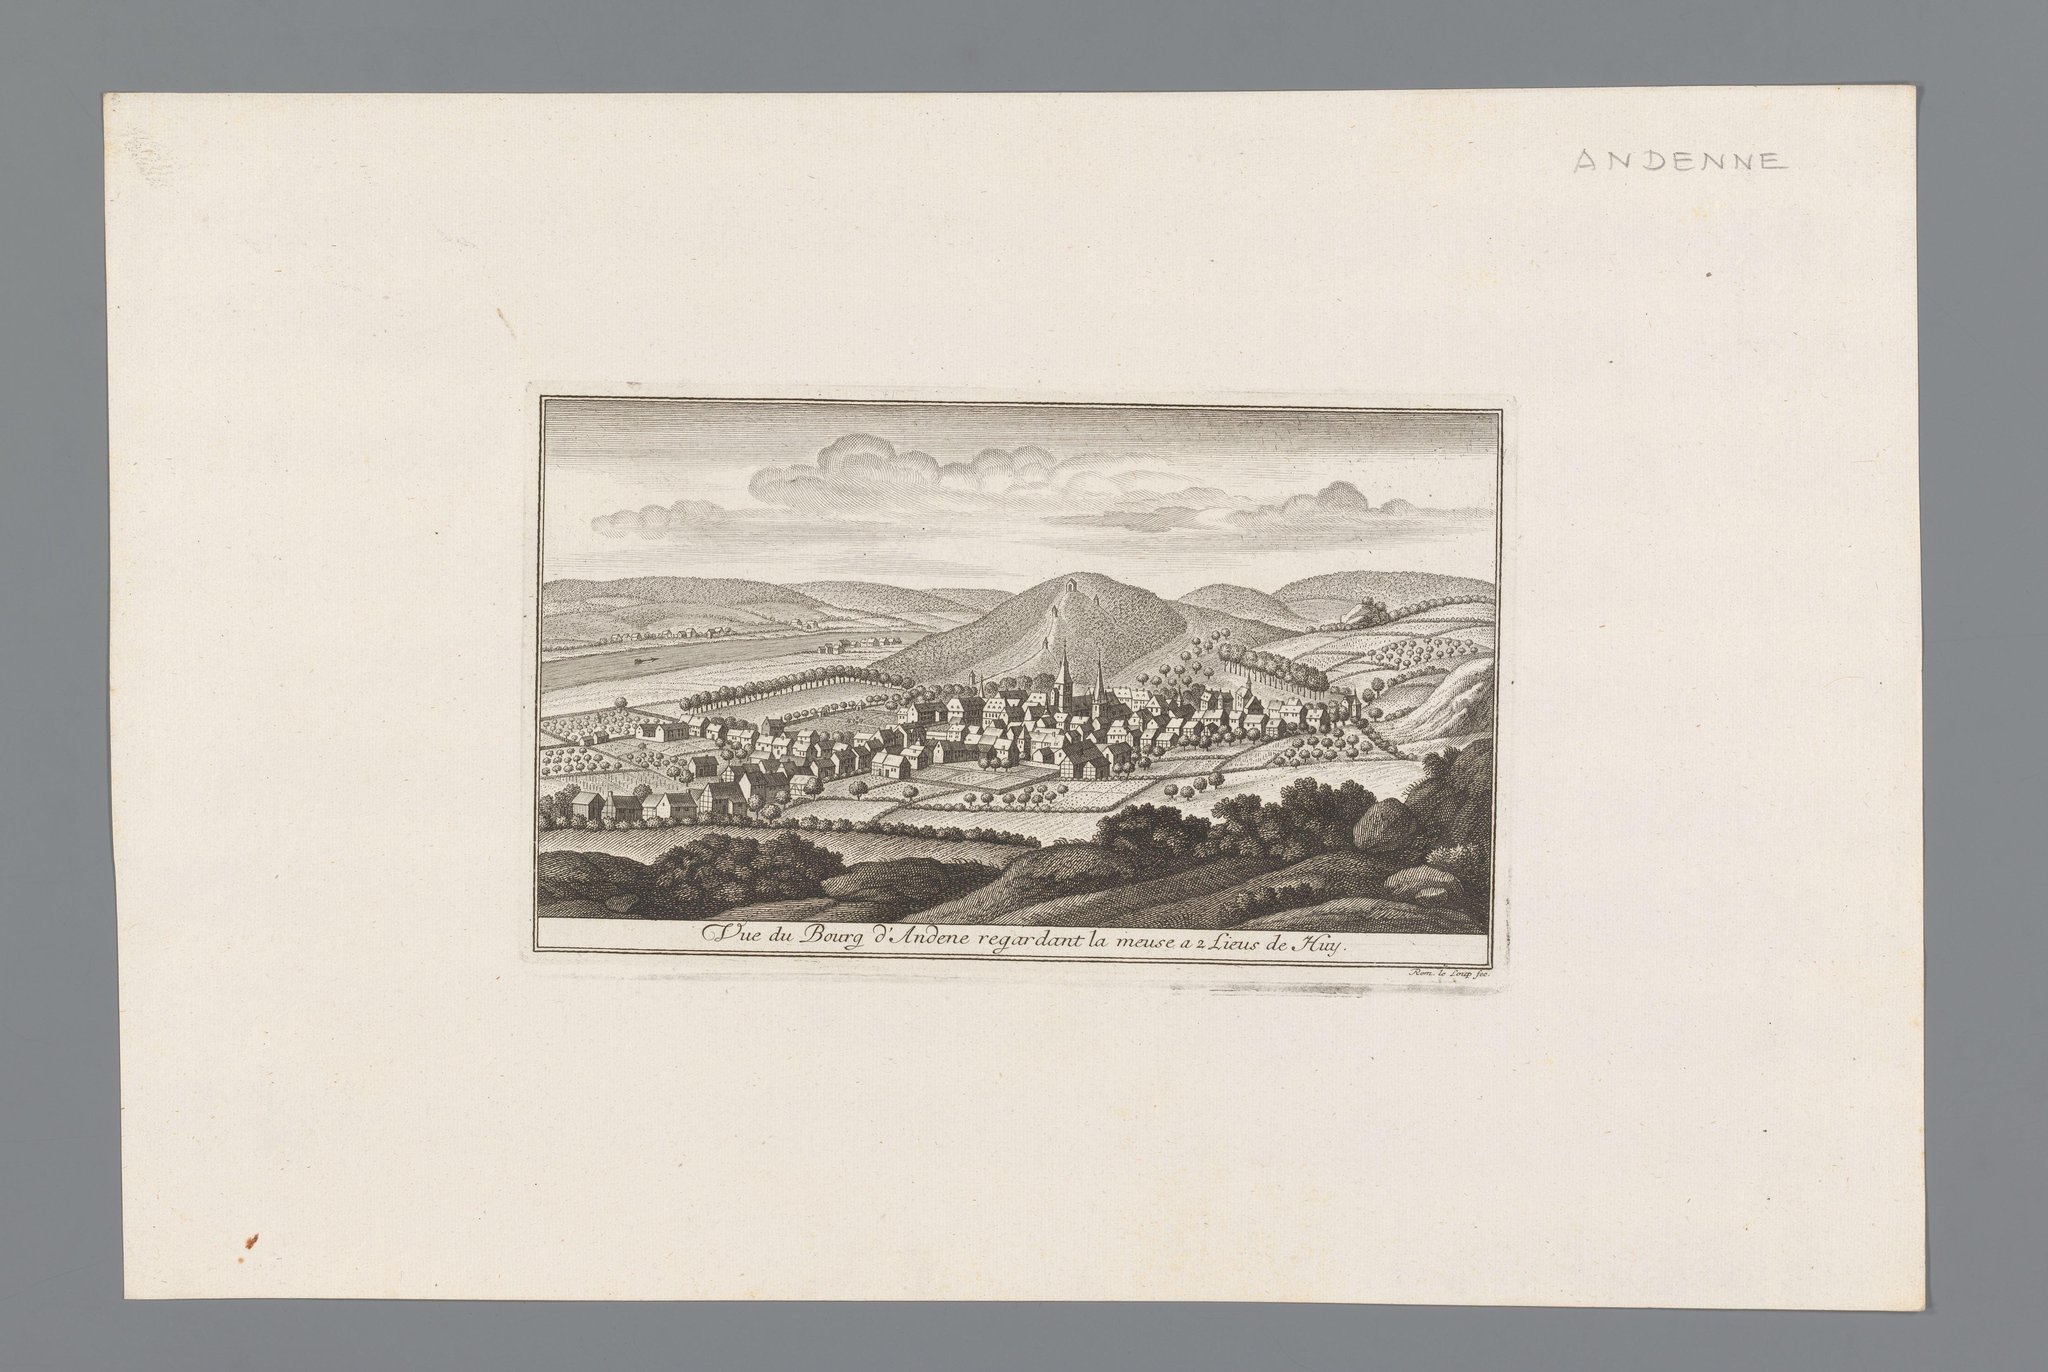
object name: print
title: Gezicht op Andenne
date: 1738-1744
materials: paper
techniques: etching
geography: liège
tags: city-view, and landscape with man-made constructions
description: Prent uit: Johanne de Saumery, Alexandre de et al. Les délices du paîs de Liège, ou description géographique, topographique et chorographique des monumes sacrés et profanes (...). 5 dln. Luik: Everard Kints, 1738-1744.